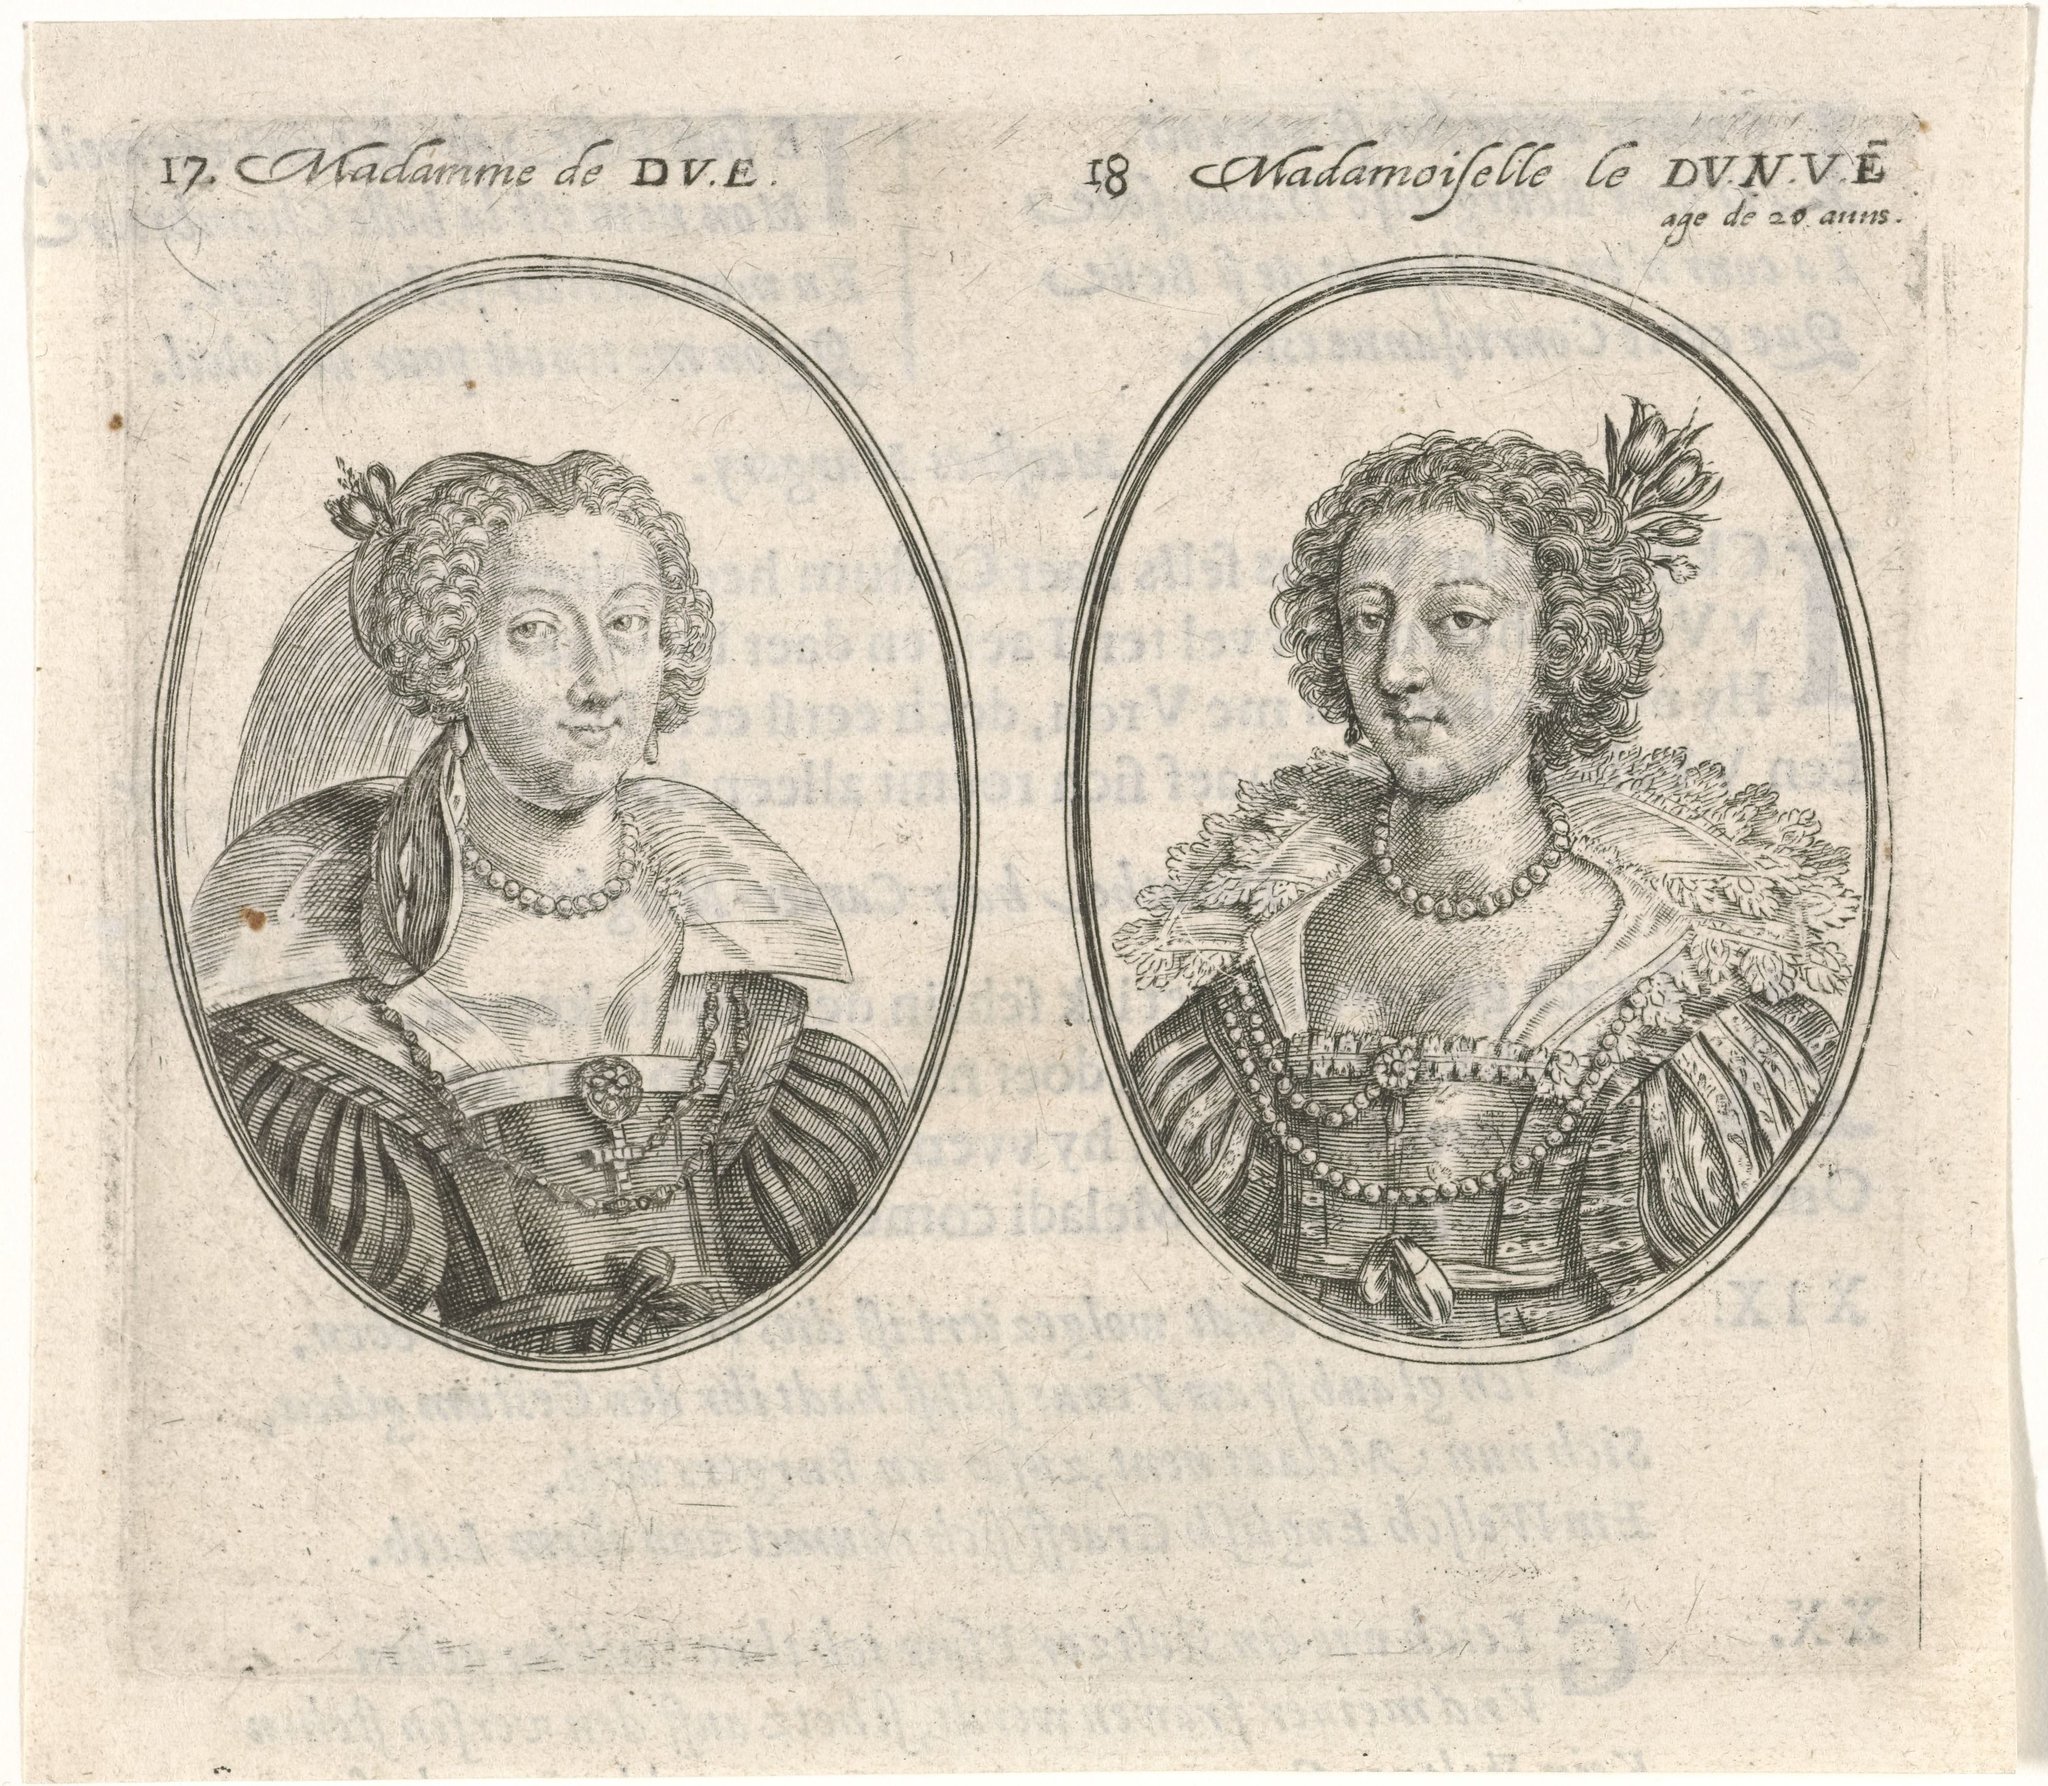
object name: book illustration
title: Portretten van twee courtisanes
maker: crispijn van de passe (ii)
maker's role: draughtsman, print maker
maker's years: 1594-1670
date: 1630-1632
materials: paper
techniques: engraving, letterpress printing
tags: whore, prostitute - cc - male prostitution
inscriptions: collector's mark: Lugt 2228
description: Prent gemaakt voor: Le miroir des courtisannes de ce temps. Verschillende edities van dit werk, uitgegeven tussen 1630 en 1710, maken gebruik van de gravures van Van der Passe óf van spiegelbeeldige kopieën ervan.